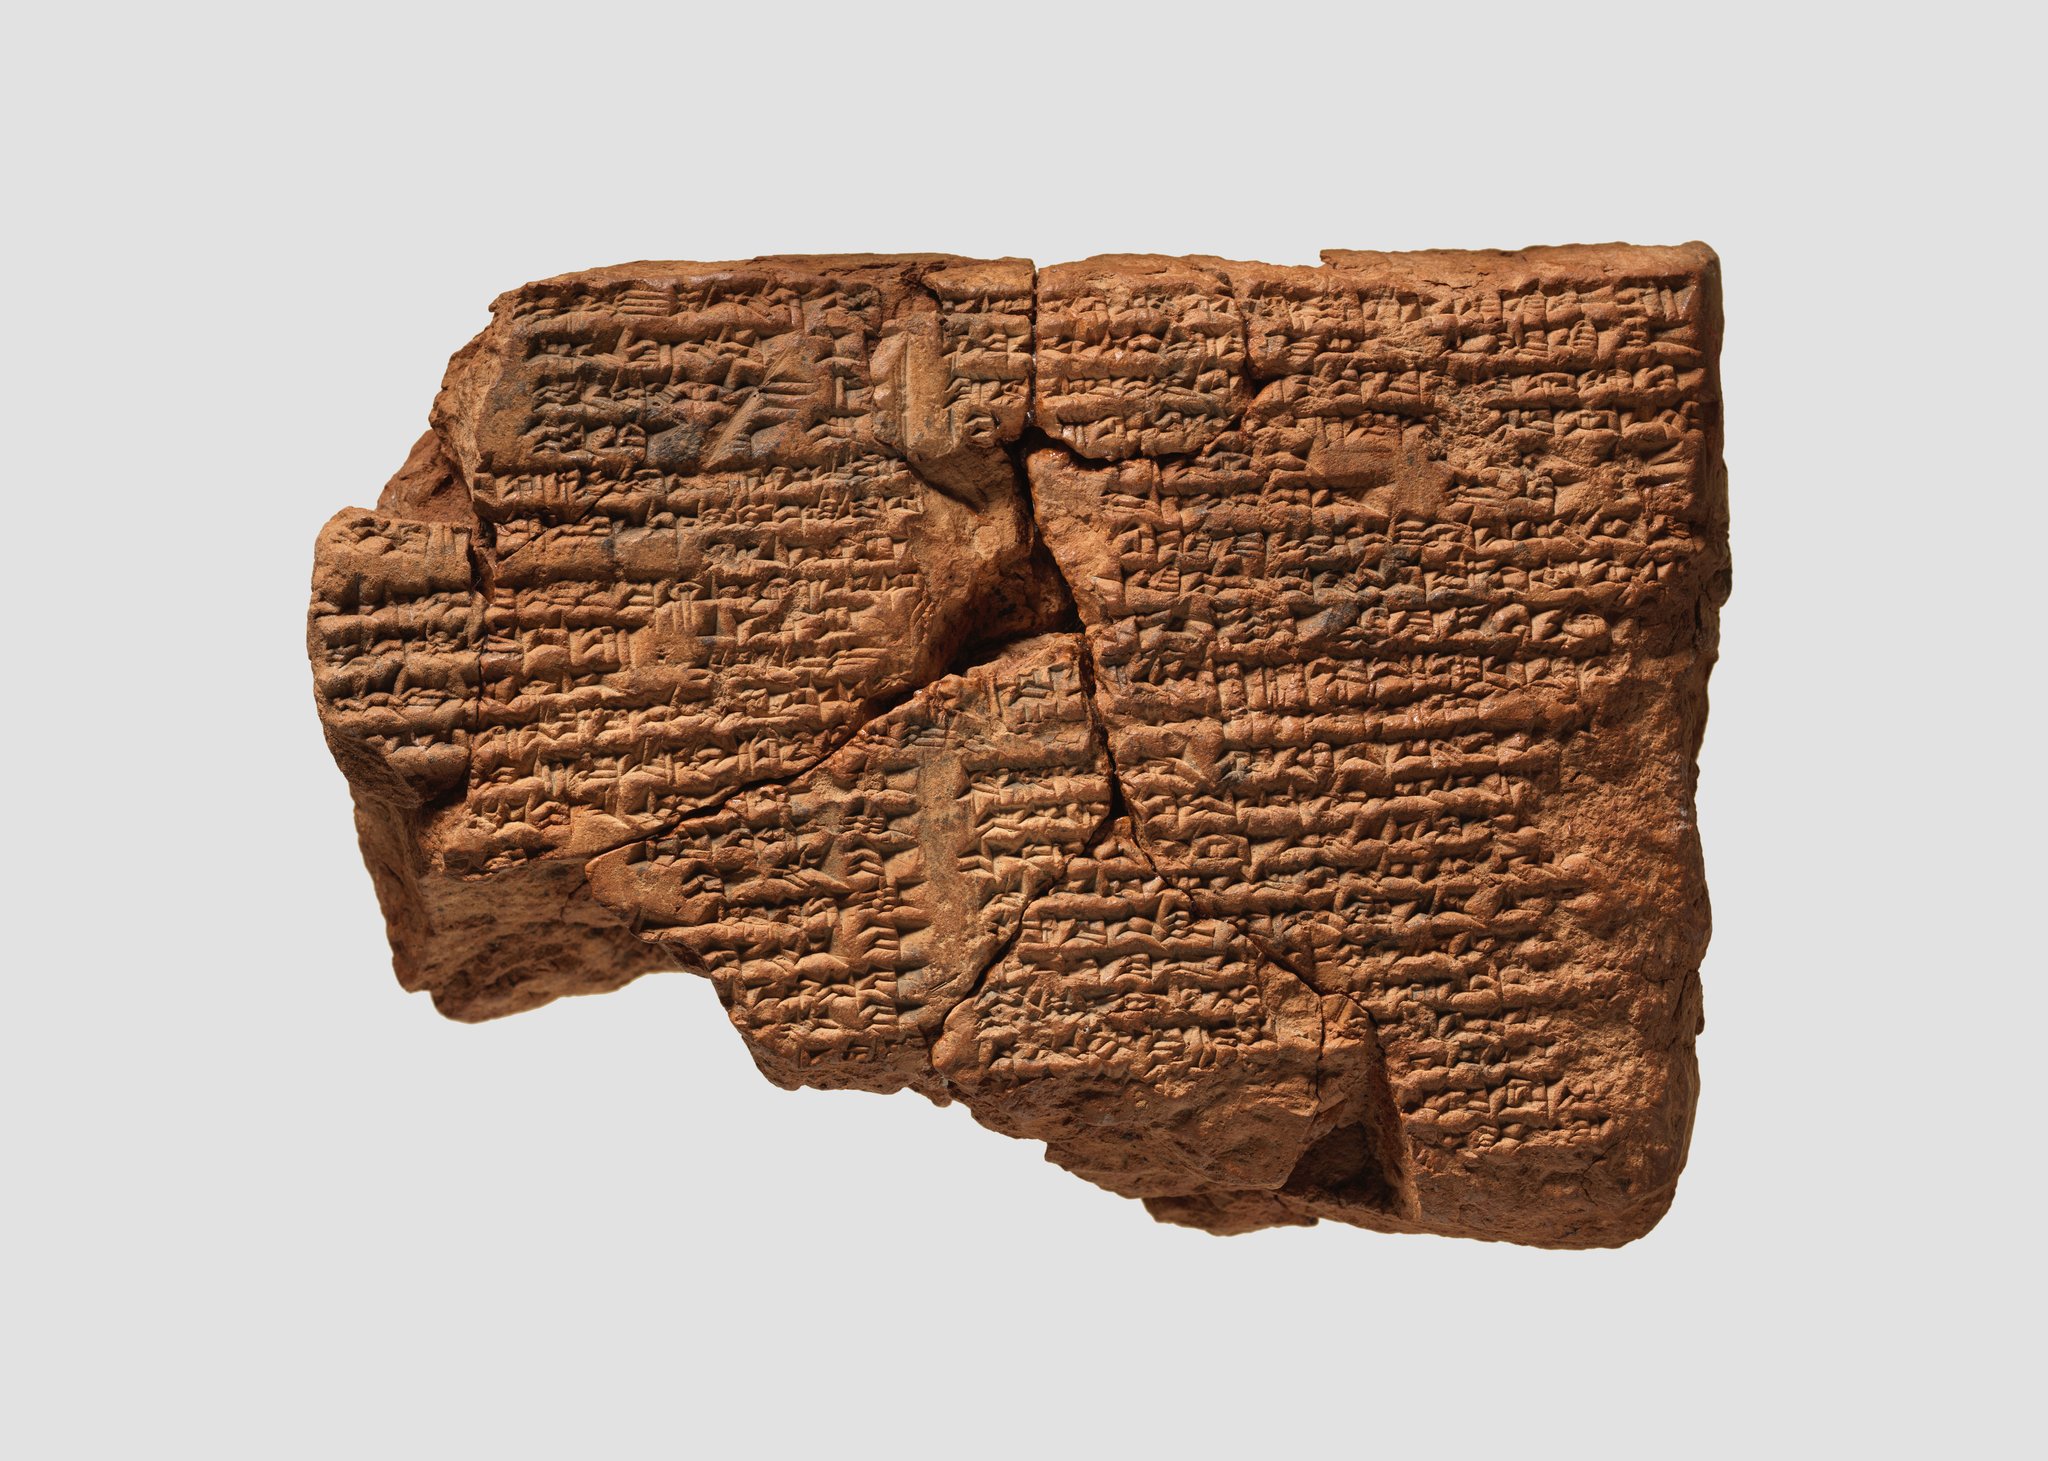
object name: cuneiform tablet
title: Cuneiform tablet: Utukku lemnutu, tablet 12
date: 333-1 BCE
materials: clay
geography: mesopotamia